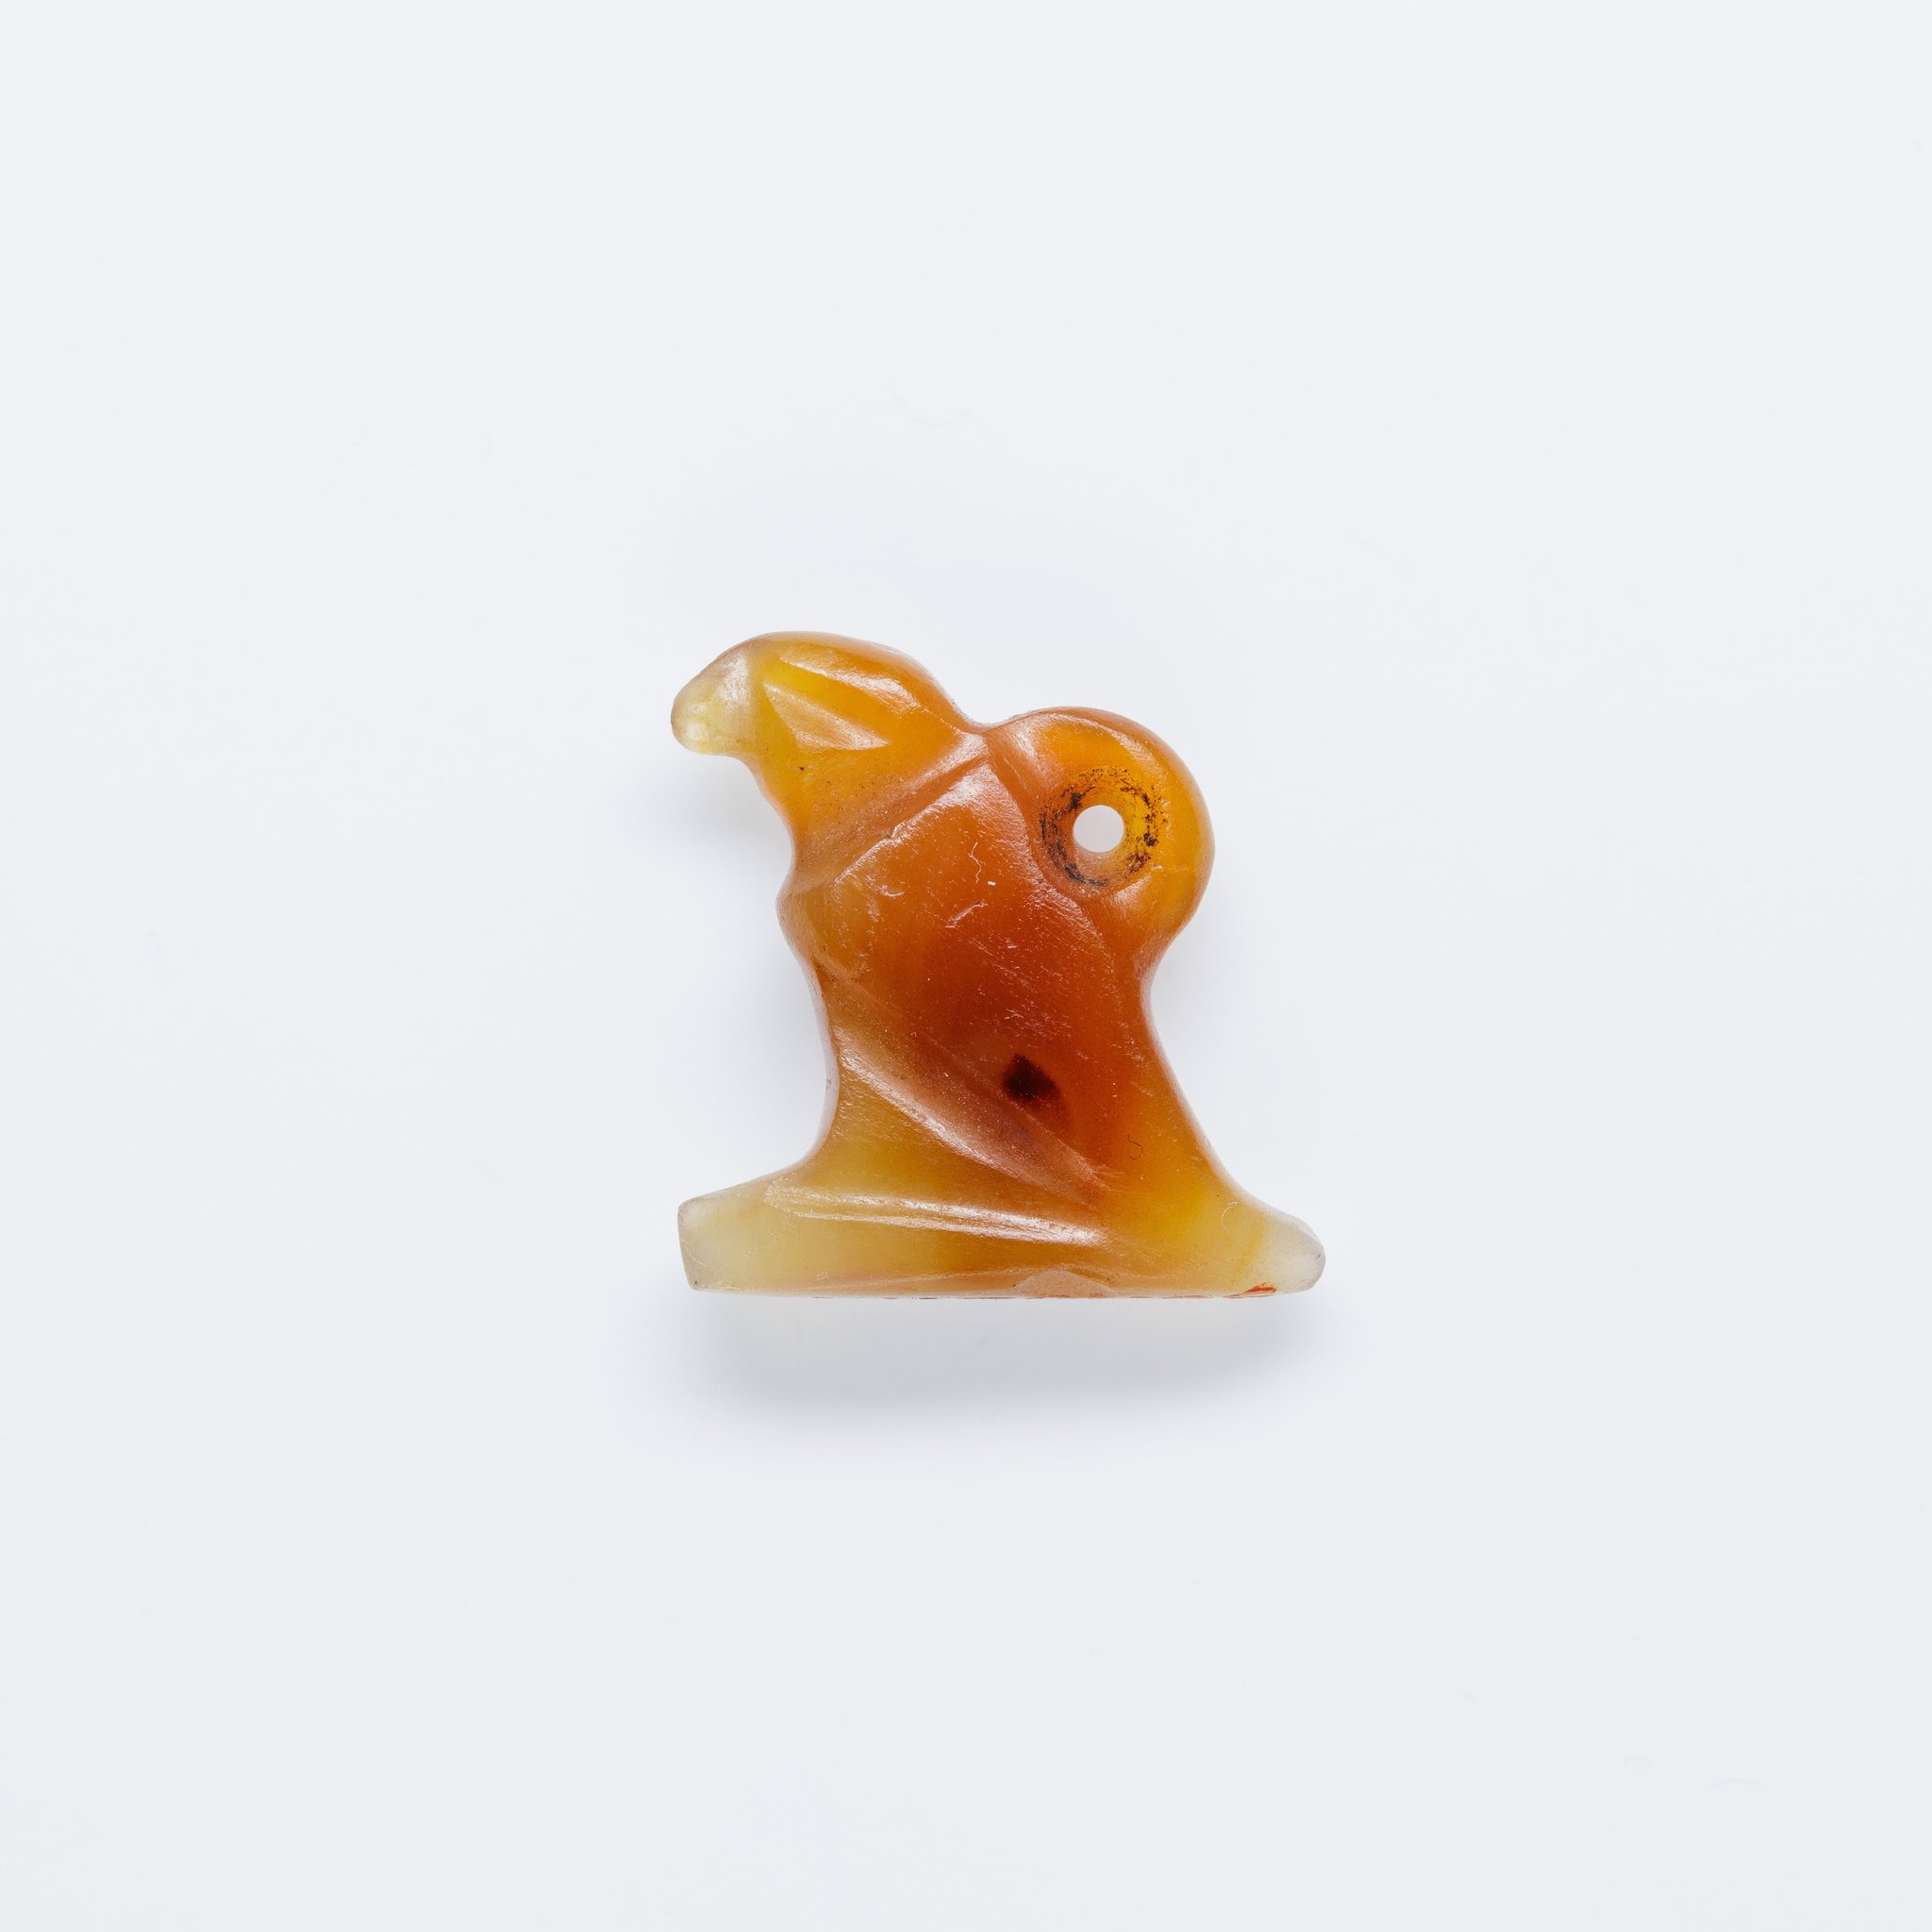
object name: amulet, falcon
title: Falcon Amulet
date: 2150-1950 BCE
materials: gemstone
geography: southern upper egypt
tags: falcons